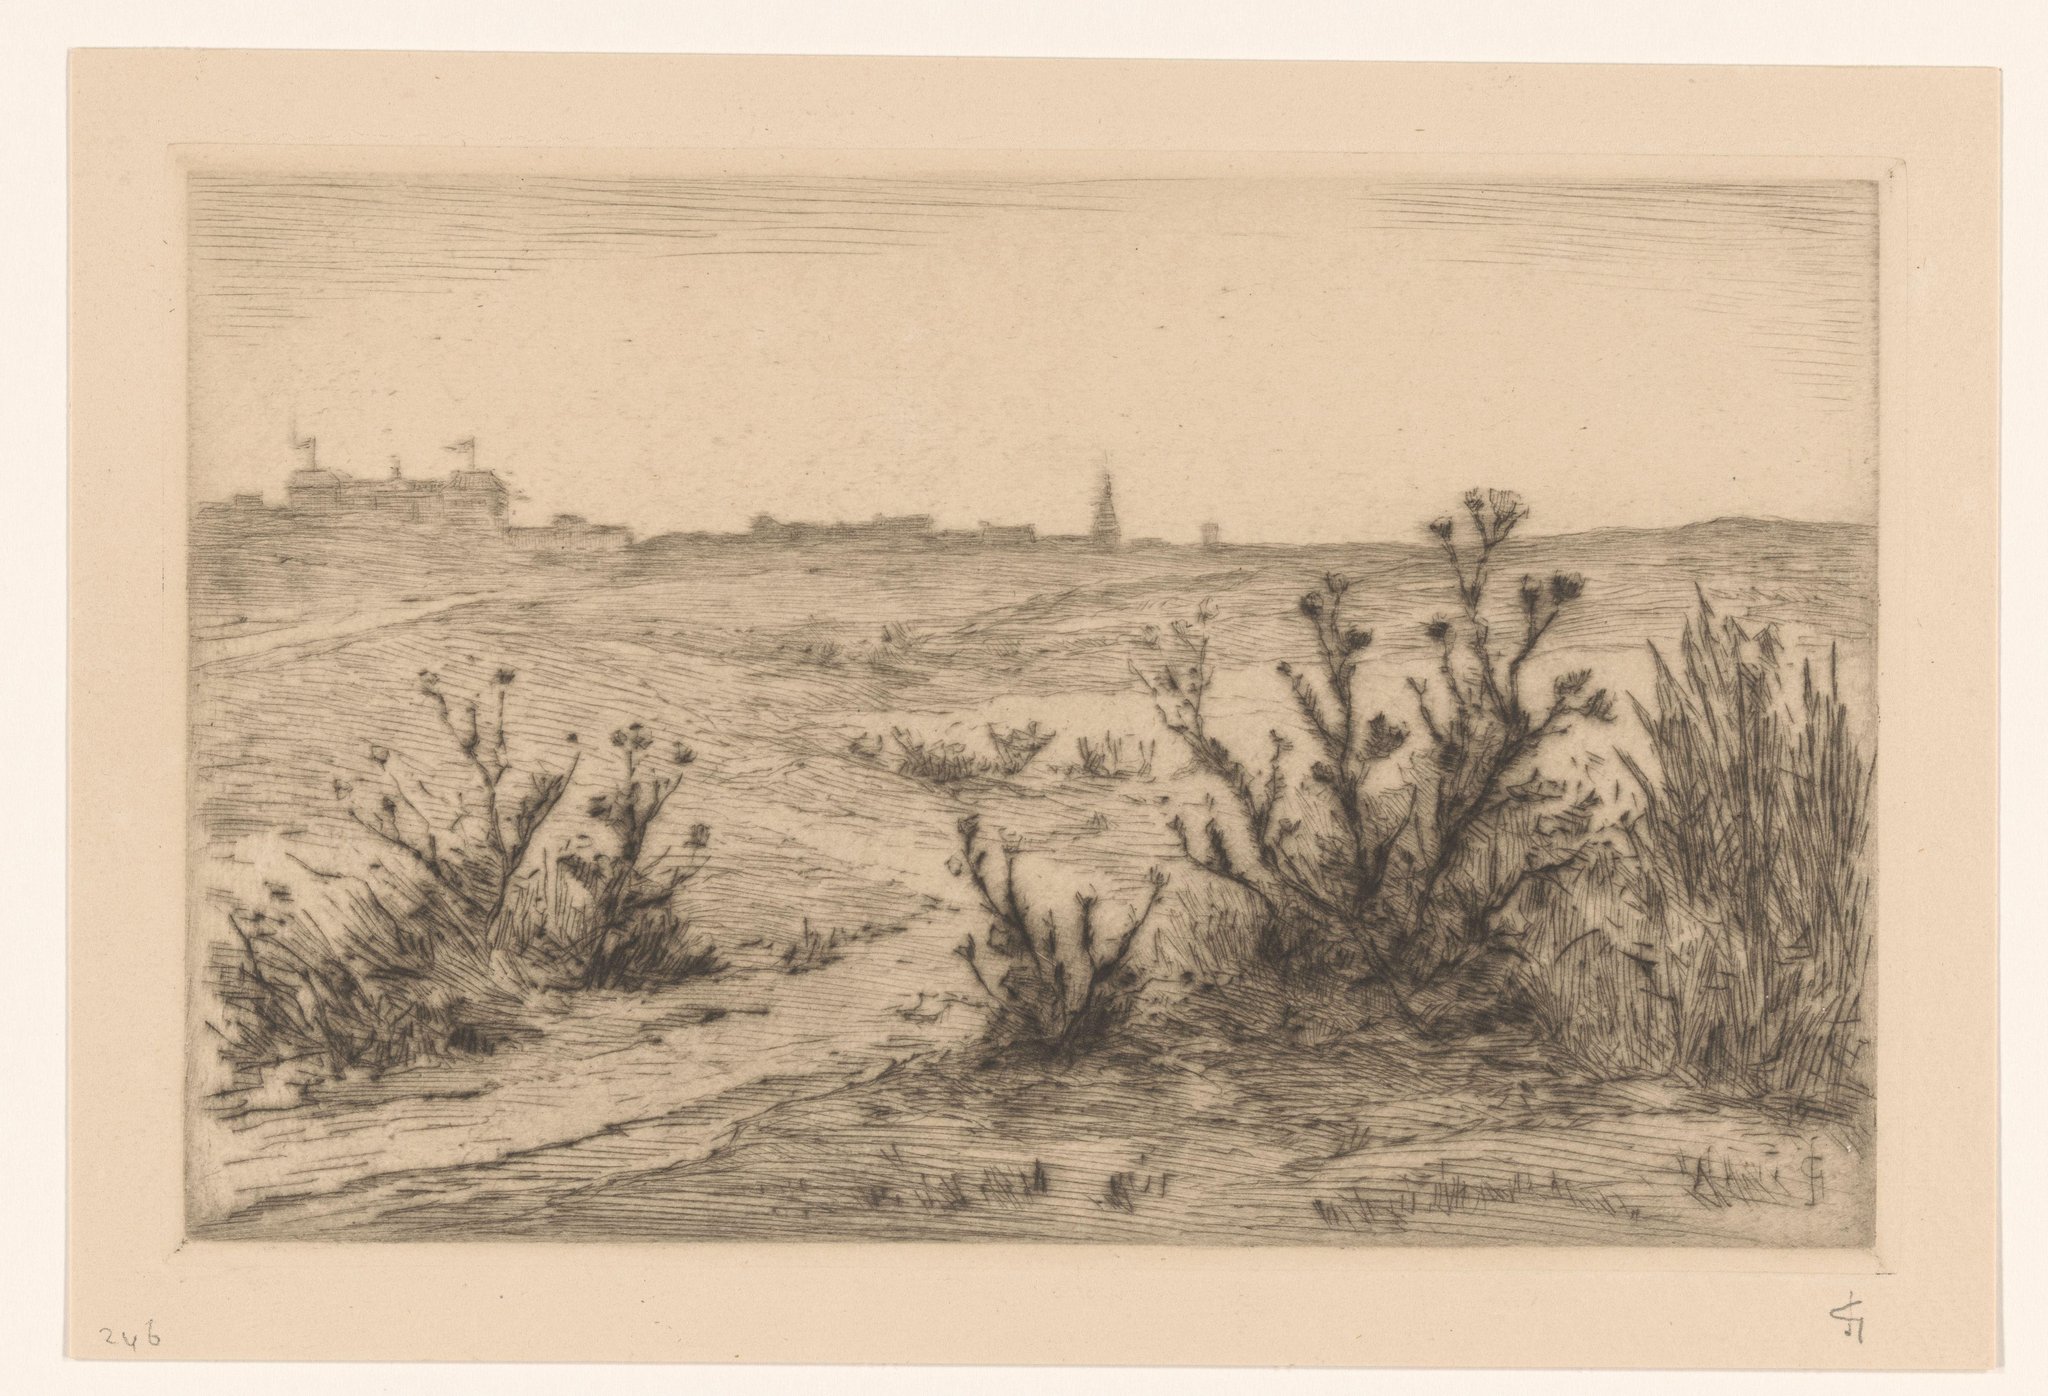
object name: print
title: Braamstruiken in de duinen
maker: carel nicolaas storm van s-gravesande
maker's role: draughtsman, print maker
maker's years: 1841-1924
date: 1887-1889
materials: paper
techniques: drypoint, intaglio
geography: netherlands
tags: prospect of village, silhouette of village, plants and herbs: bramble, dunes (sea not visible); in the dunes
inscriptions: collector's mark: Lugt 2228